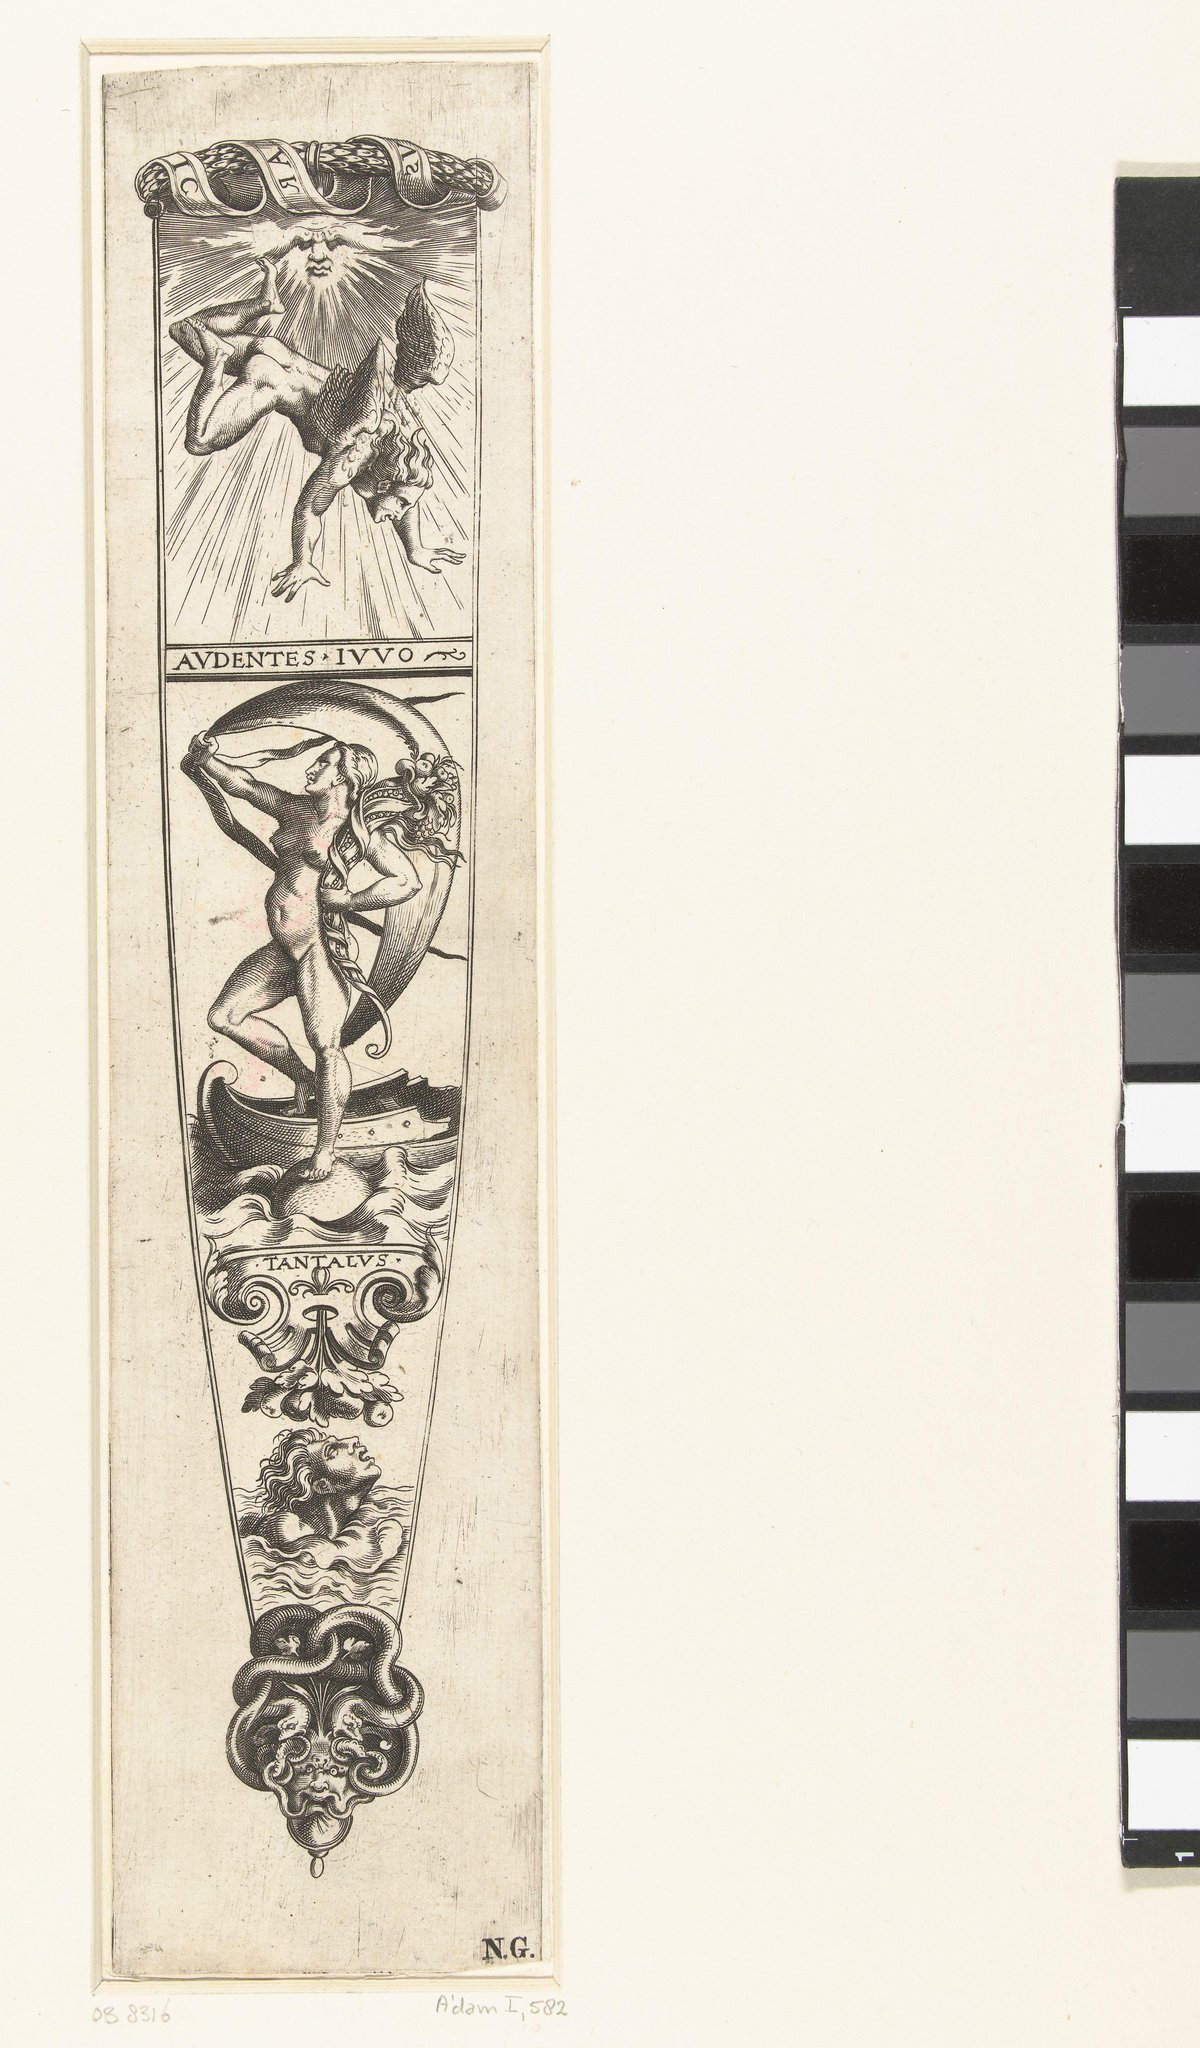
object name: print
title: Dolkschede met bovenaan de val van Icarus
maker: Anonymous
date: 1500-1600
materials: paper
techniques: etching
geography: france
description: In het midden het Genot (?) in de gedaante van een vrouw met een hoorn des overvloeds, en onderaan Tantalus.